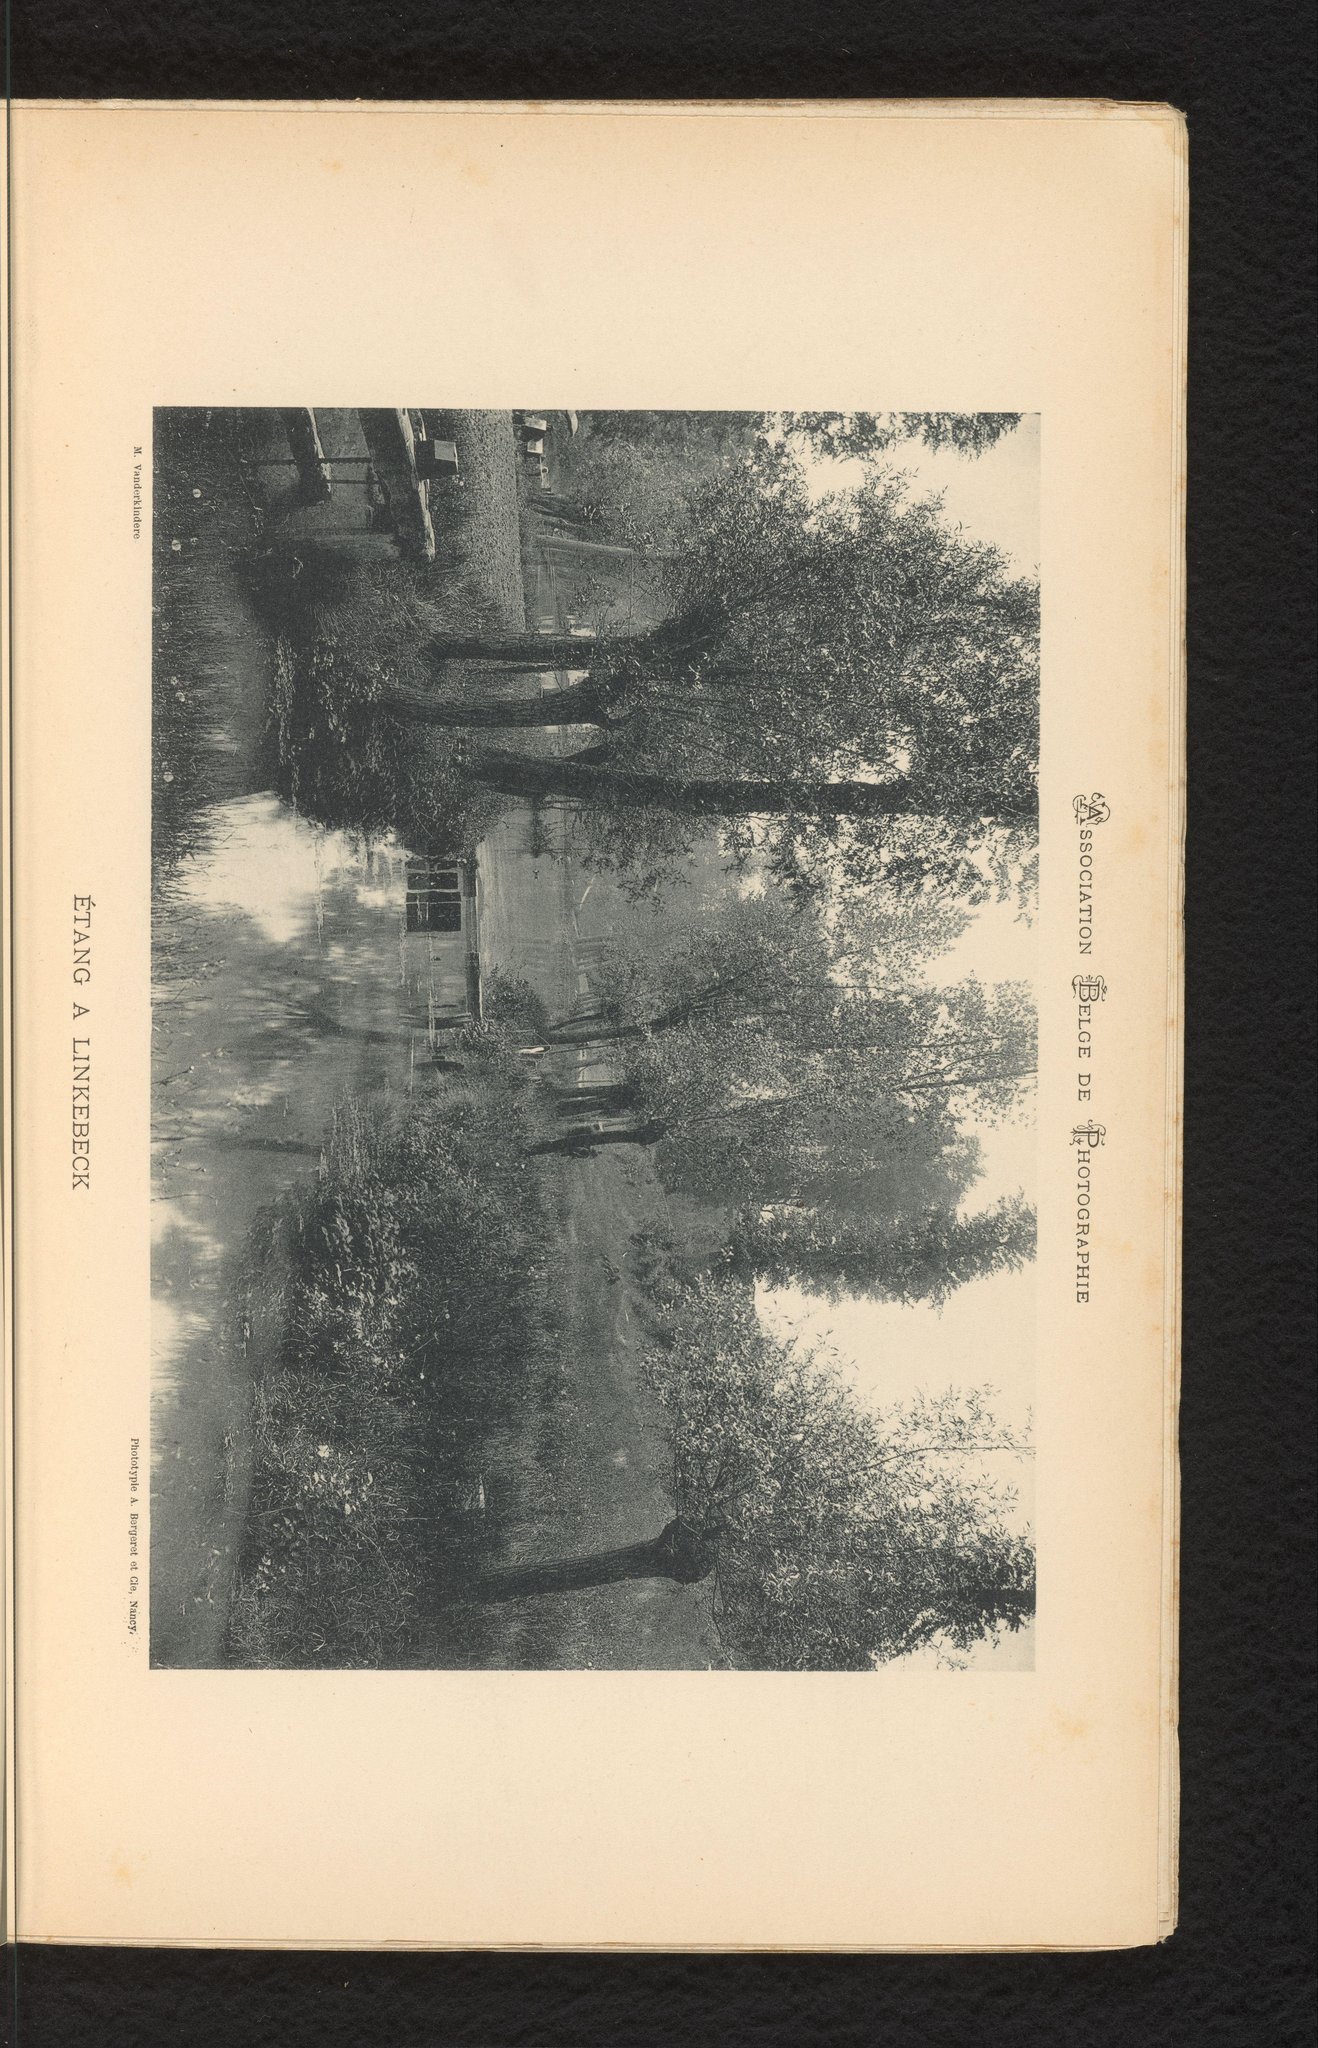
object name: photomechanical print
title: Sloot bij Linkebeek, België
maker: marcel vanderkindere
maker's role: fotograaf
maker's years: 1864-1941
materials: paper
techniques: photograph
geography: linkebeek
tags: small canal, ditch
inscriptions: inscription: ‘Association Belge de Photographie’